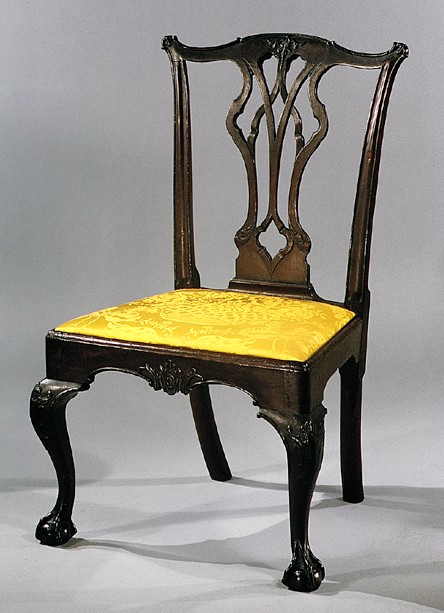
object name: side chair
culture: american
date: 1760-1790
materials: wood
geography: united states